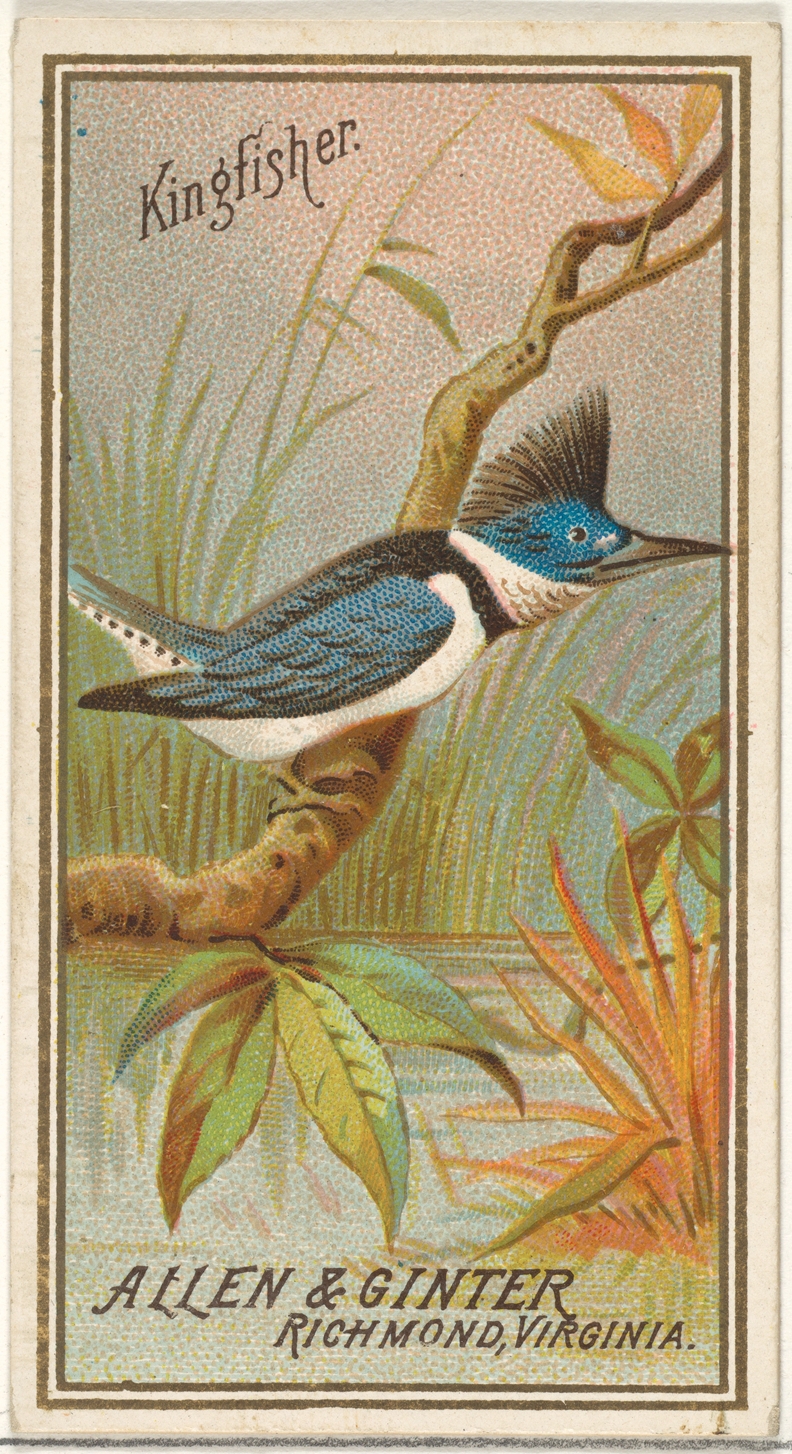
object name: print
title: Kingfisher, from the Birds of America series (N4) for Allen & Ginter Cigarettes Brands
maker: allen & ginter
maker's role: publisher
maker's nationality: american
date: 1888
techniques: color lithograph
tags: birds